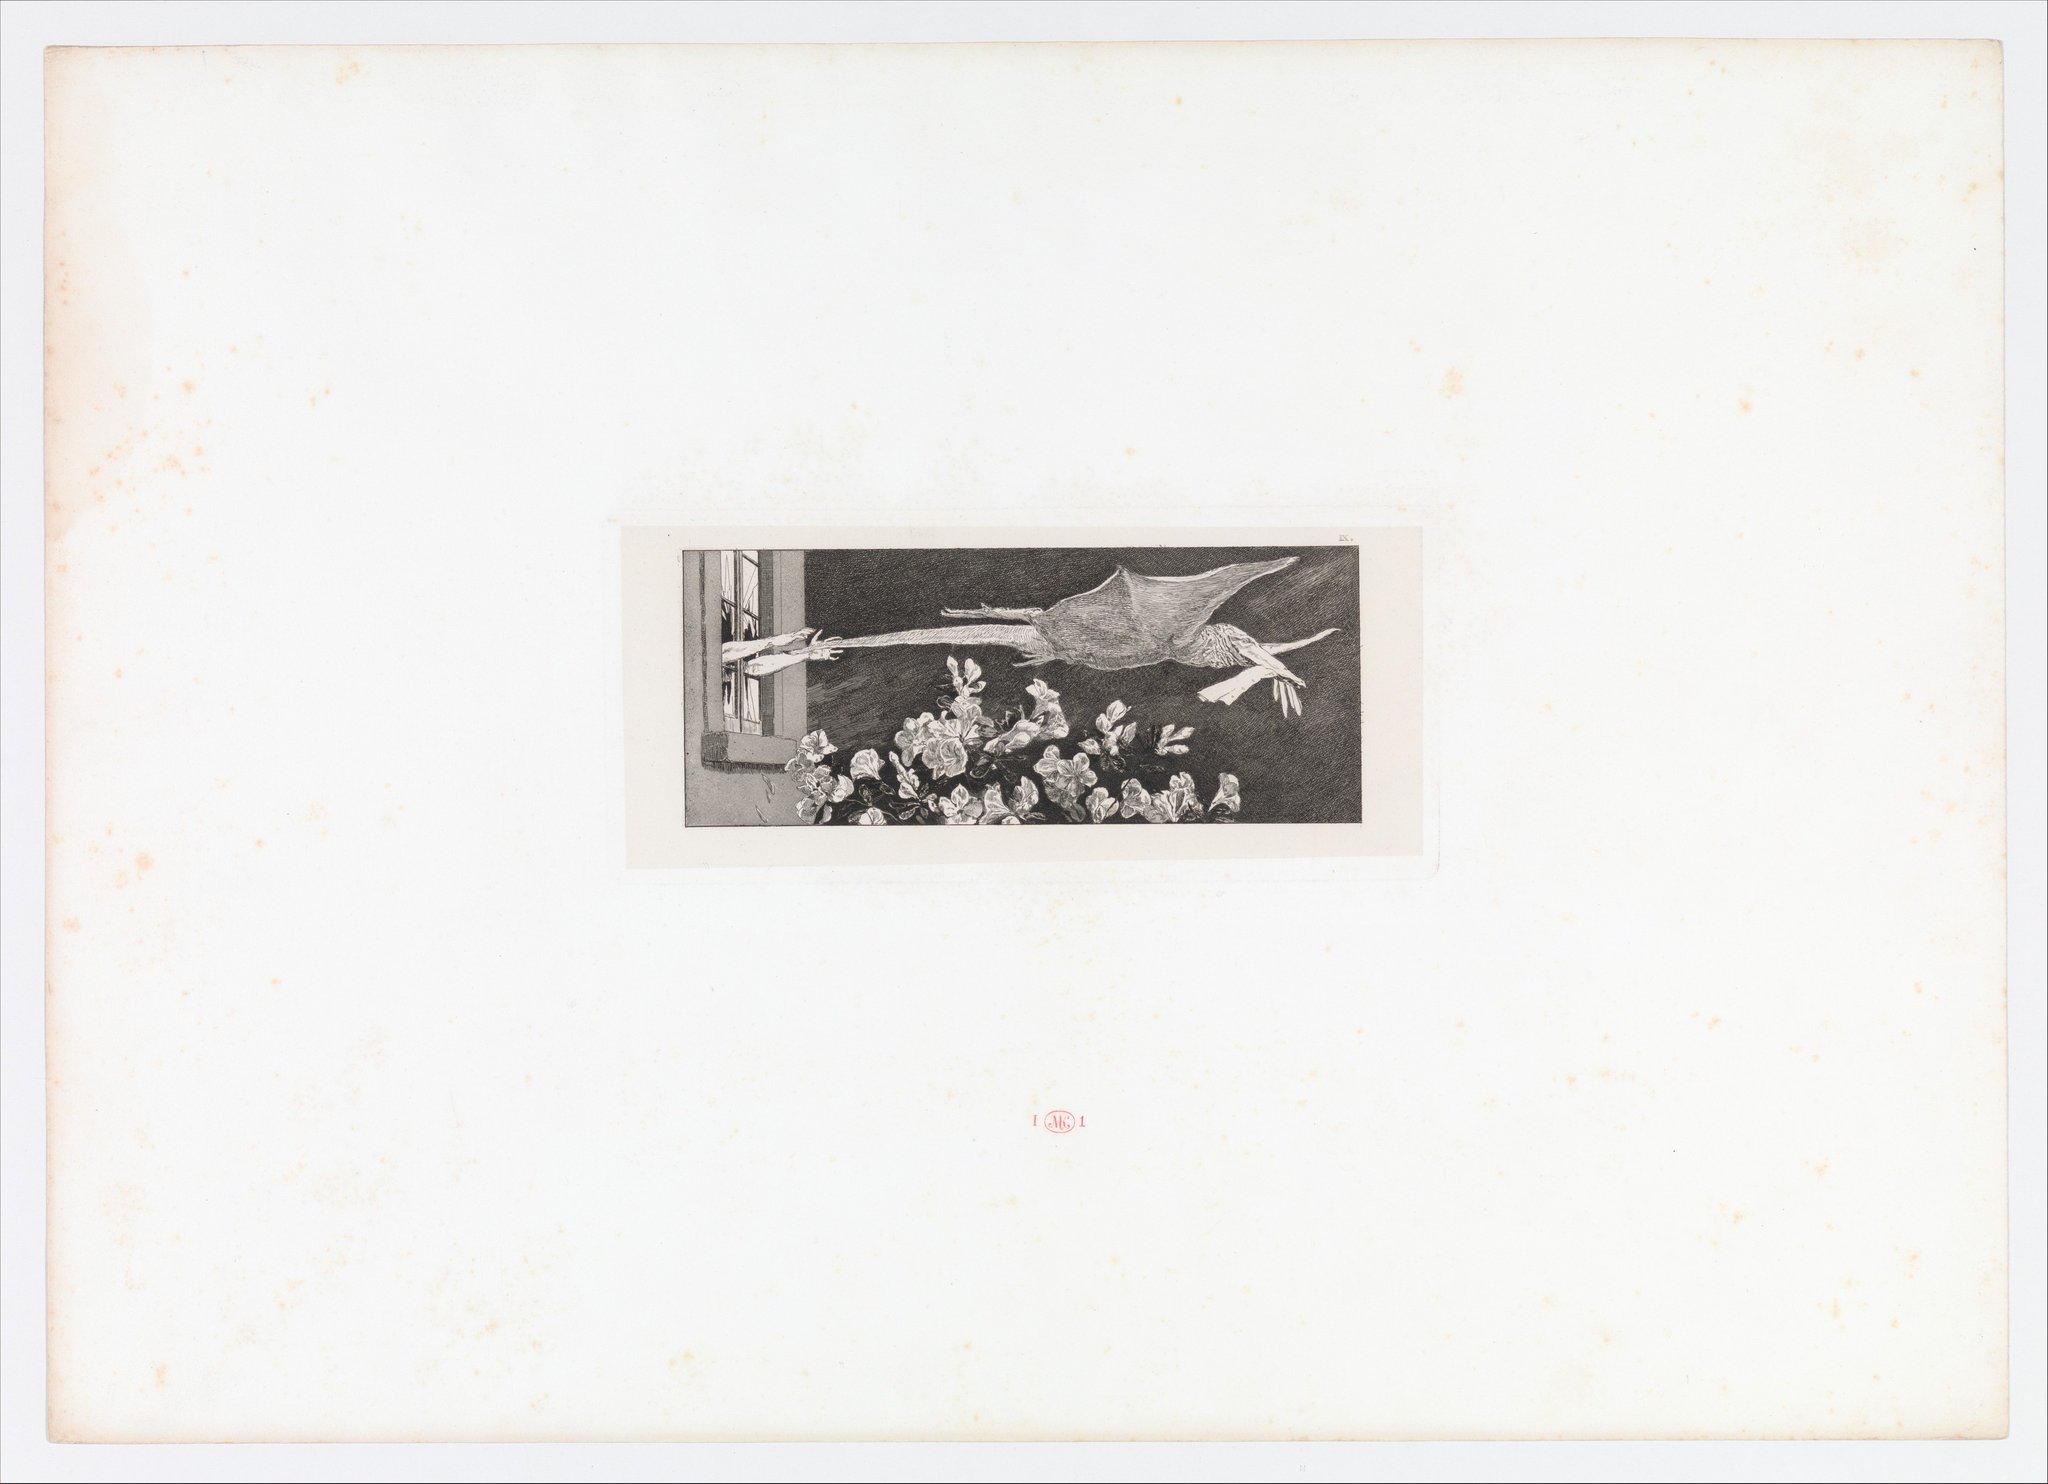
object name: print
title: Abduction (plate nine from Paraphrase on the Finding of a Glove)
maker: max klinger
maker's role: artist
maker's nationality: german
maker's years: 1857-1920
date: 1881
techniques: aquatint, printmaking, drypoint, etching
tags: birds,hands,flowers